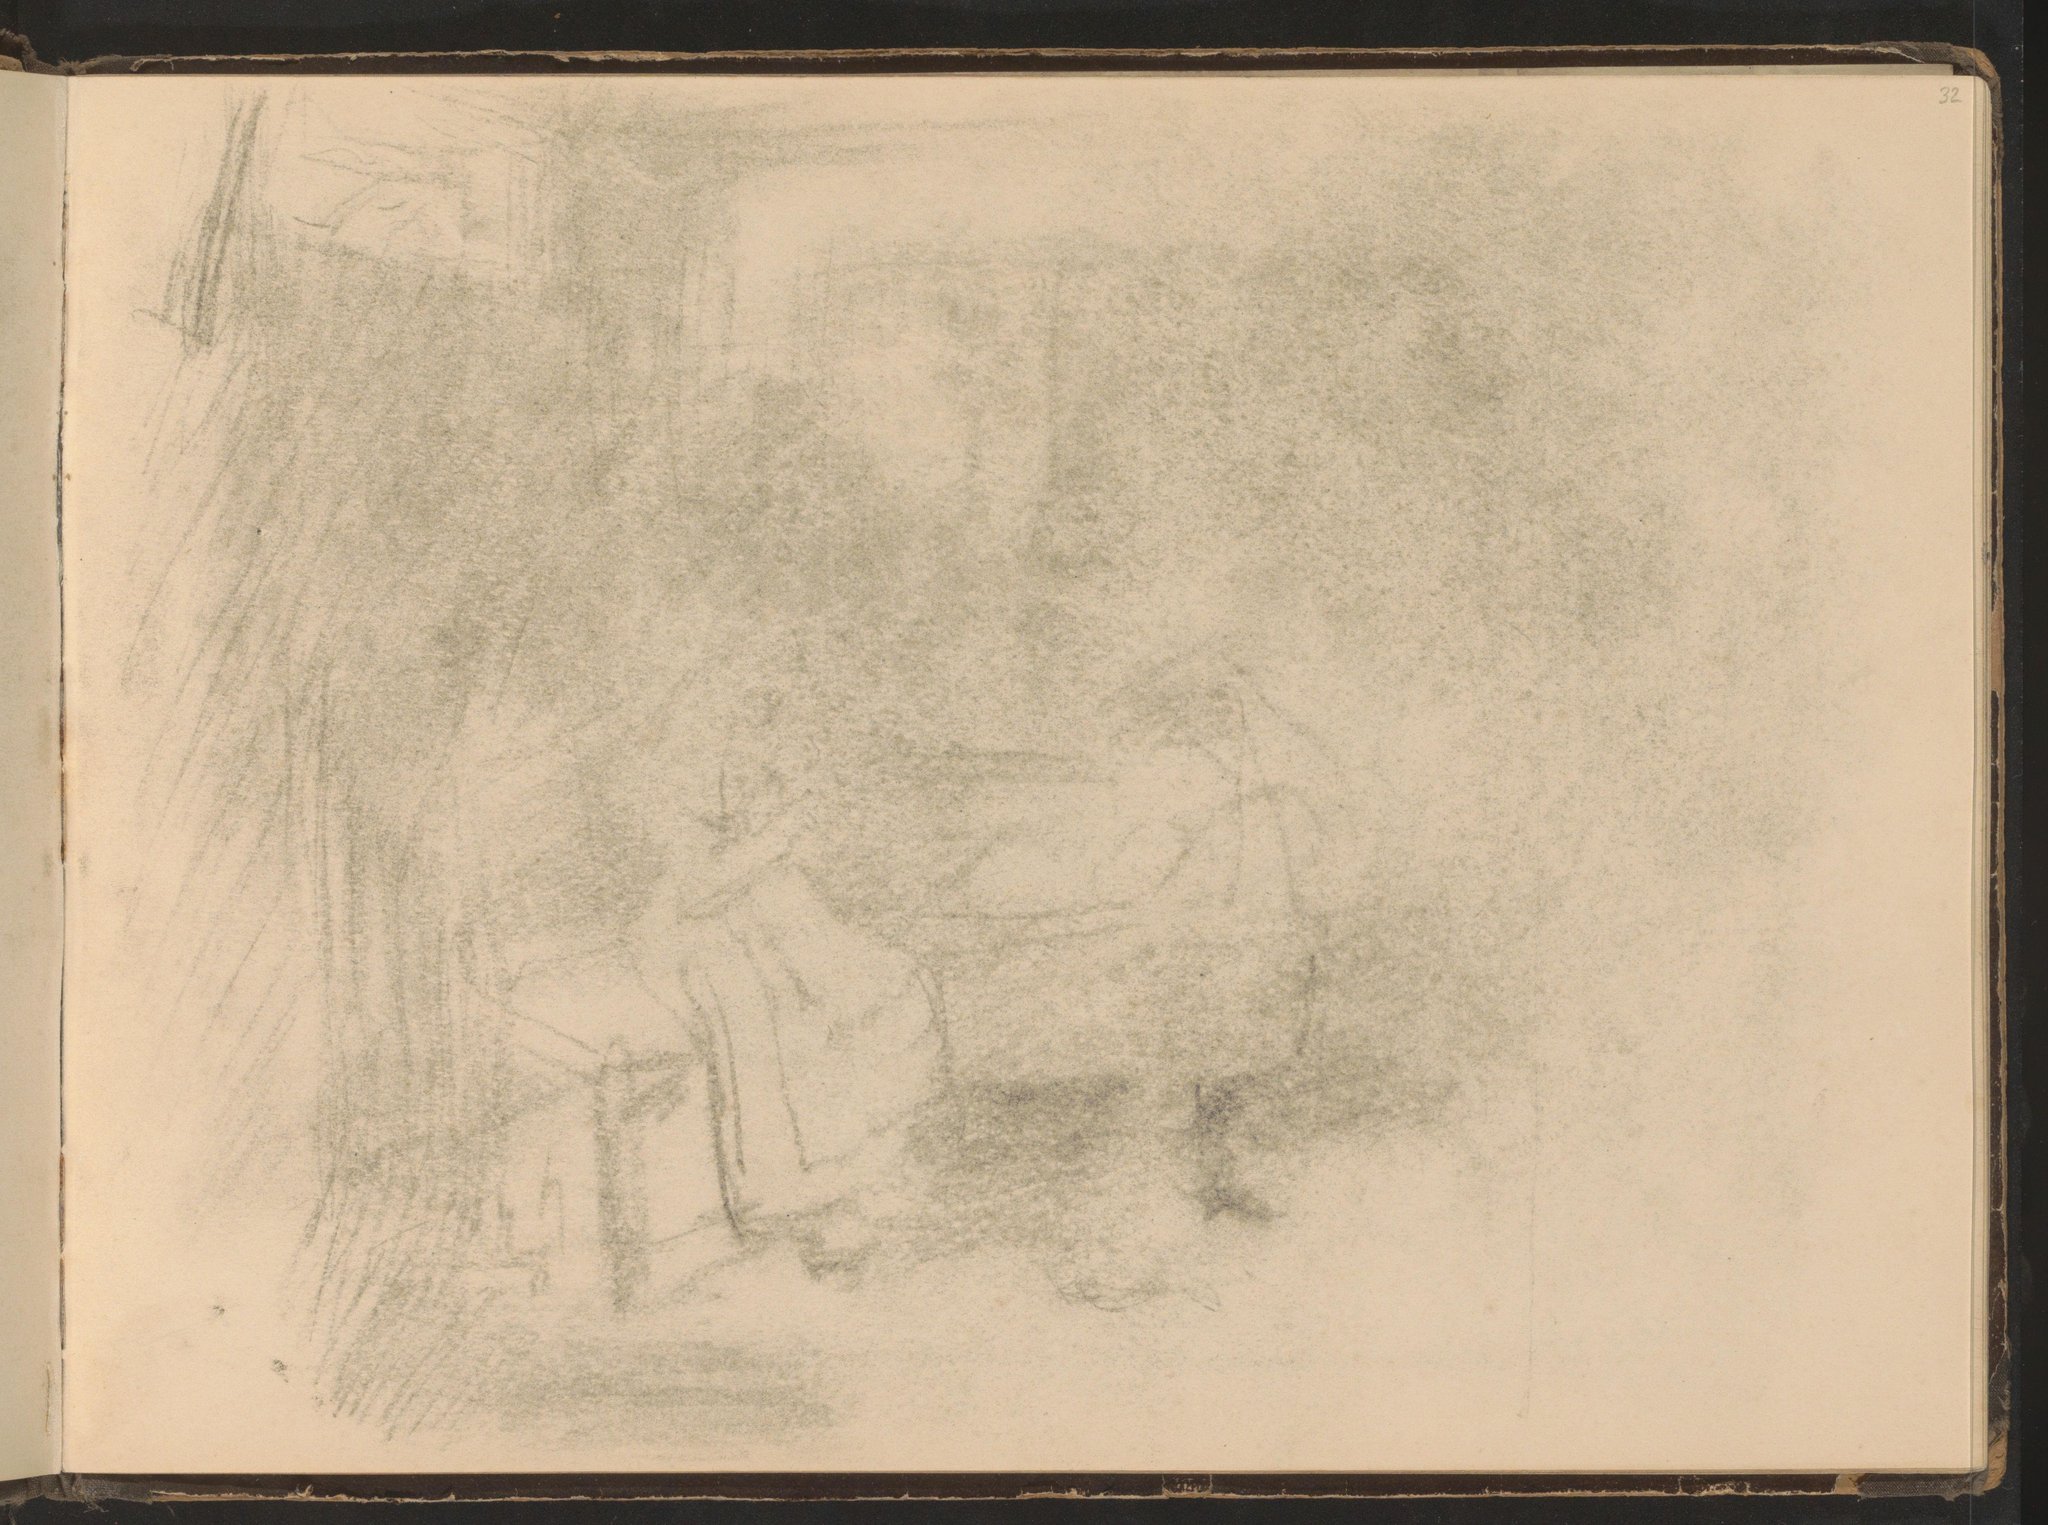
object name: sketchbook leaf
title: Interieur met een zittend meisje op een stoel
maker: albert neuhuys (1844-1914)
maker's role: draughtsman, painter, print maker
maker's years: 1844-1914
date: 1854-1914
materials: charcoal, paper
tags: sitting figure, girl (child between toddler and youth), interior of the house, chair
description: Blad 32 recto uit een schetsboek met 43 bladen.